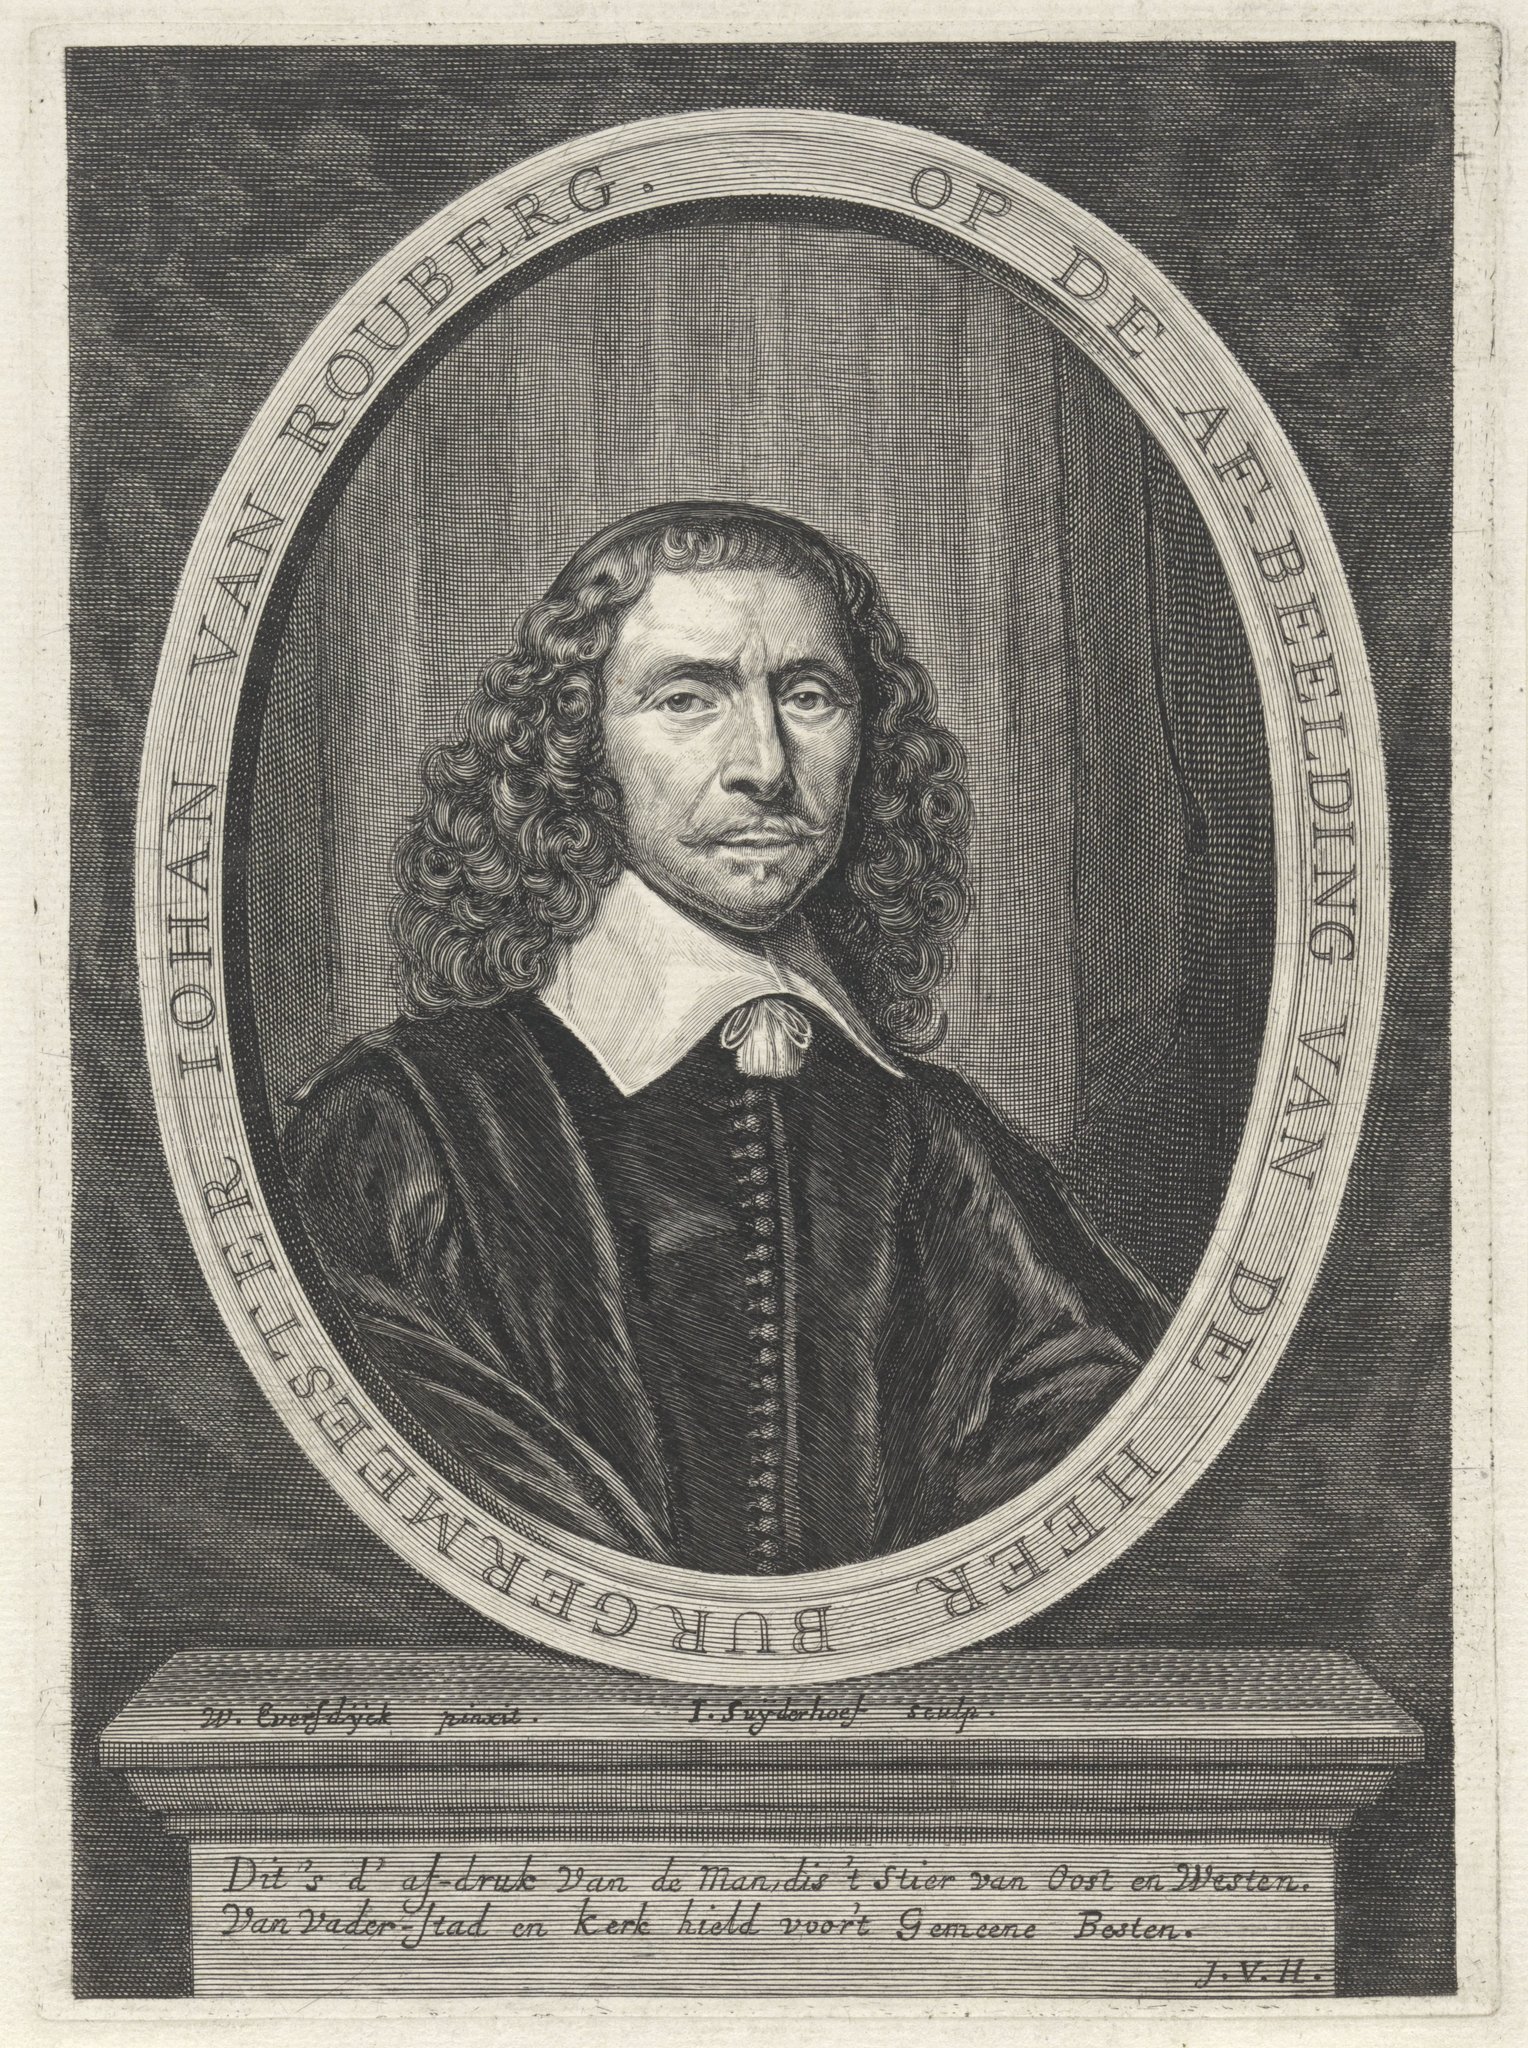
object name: print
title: Portret van Johan van Roubergen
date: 1647-1686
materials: paper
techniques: engraving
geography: haarlem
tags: mayor, mayor, burgomaster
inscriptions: collector's mark: Lugt 240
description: Portret van Johan van Roubergen, burgemeester van Middelburg, in een ovale lijst. De lijst staat op een sokkel met een tweeregelig opschrift in het Nederlands.